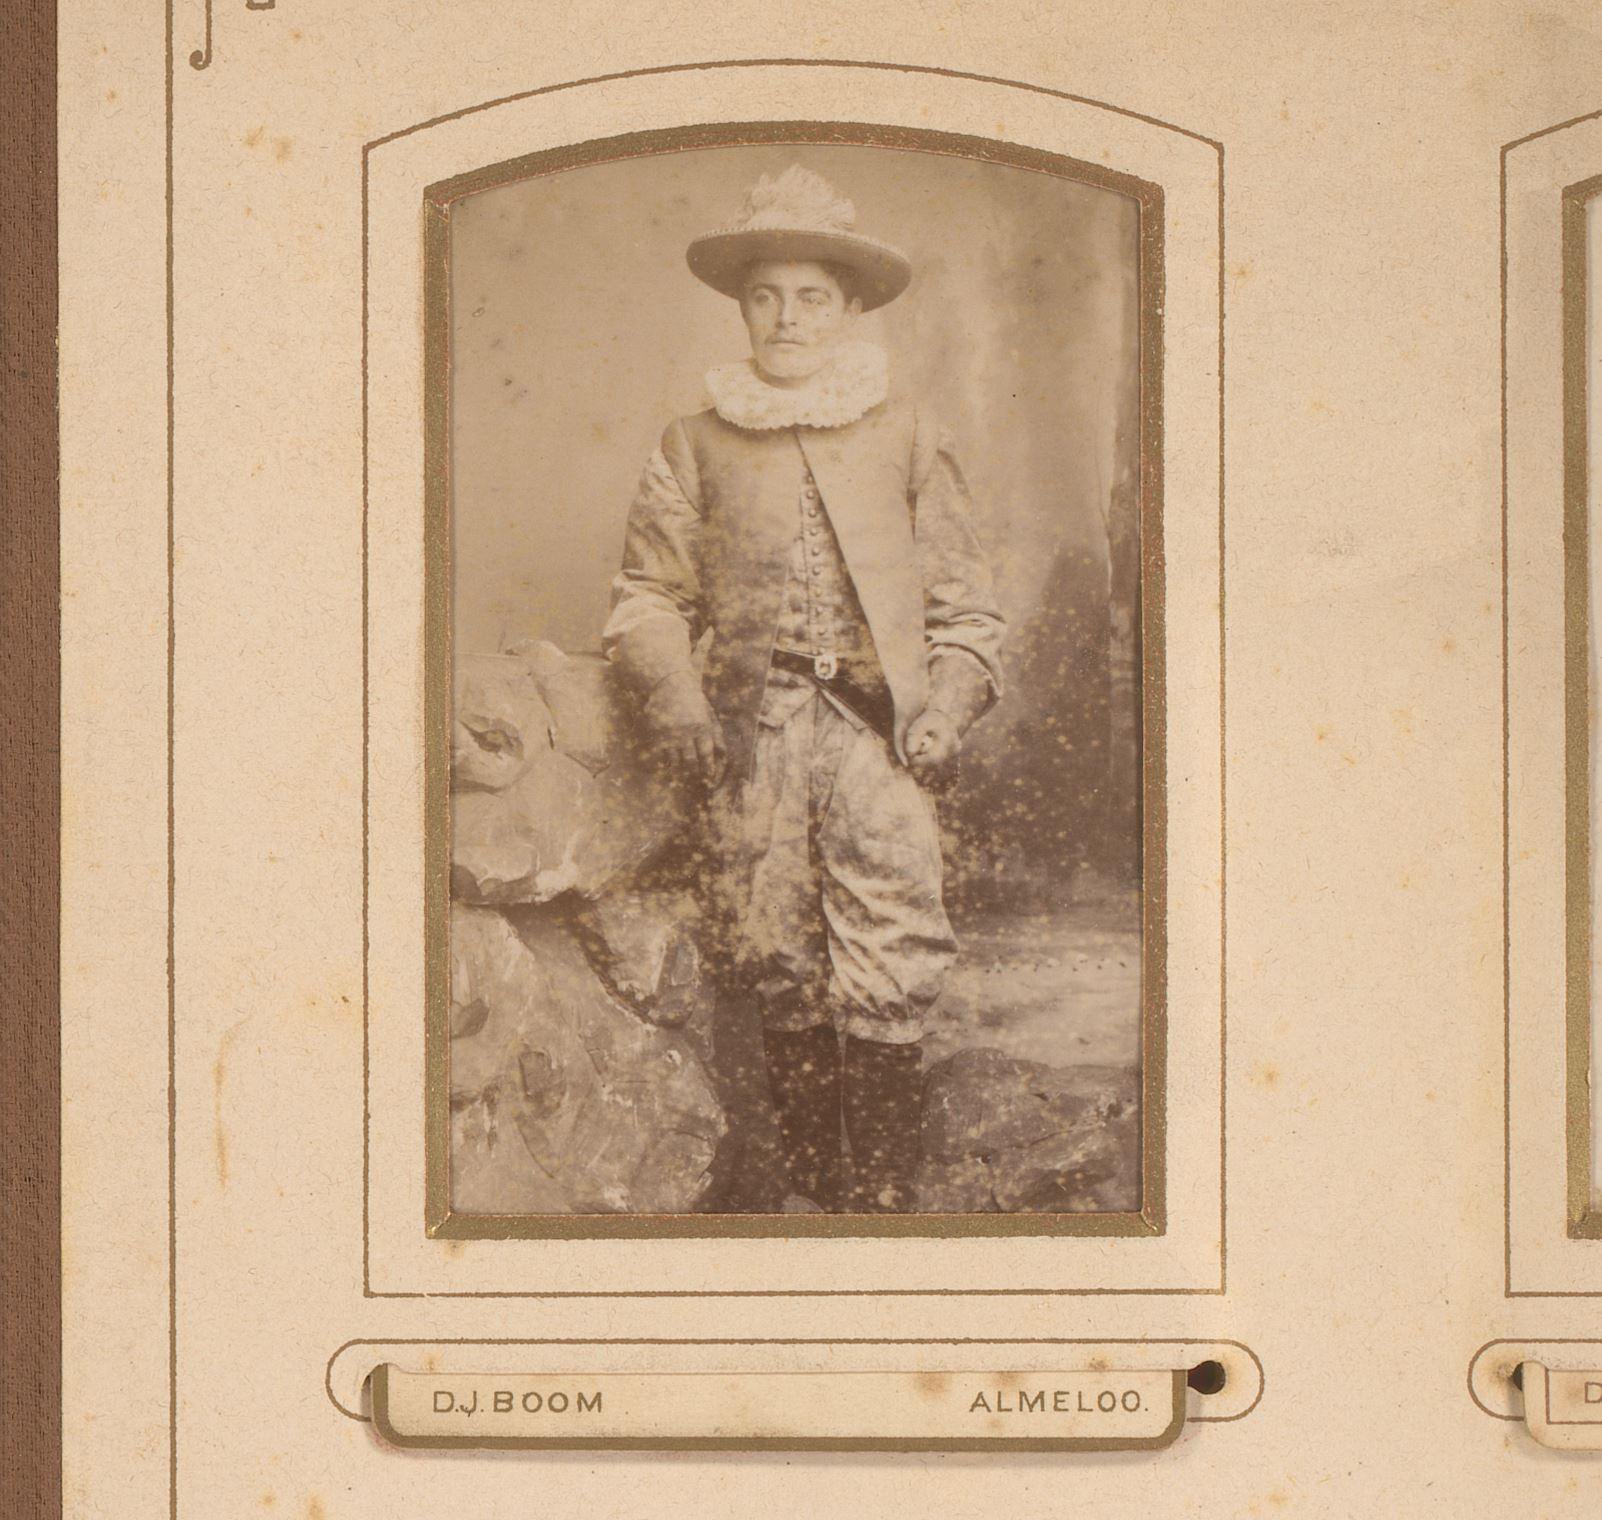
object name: carte de visite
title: Portret van een man met hoed en kraag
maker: derk jan boom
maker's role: draughtsman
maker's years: 1853-1935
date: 1888-1905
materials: cardboard, photographic support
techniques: albumen print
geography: almelo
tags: historical persons, head-gear: hat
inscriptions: inscription: ‘D.J. Boom/ Photograaf/ Portretteekenaar/ Almeloo’